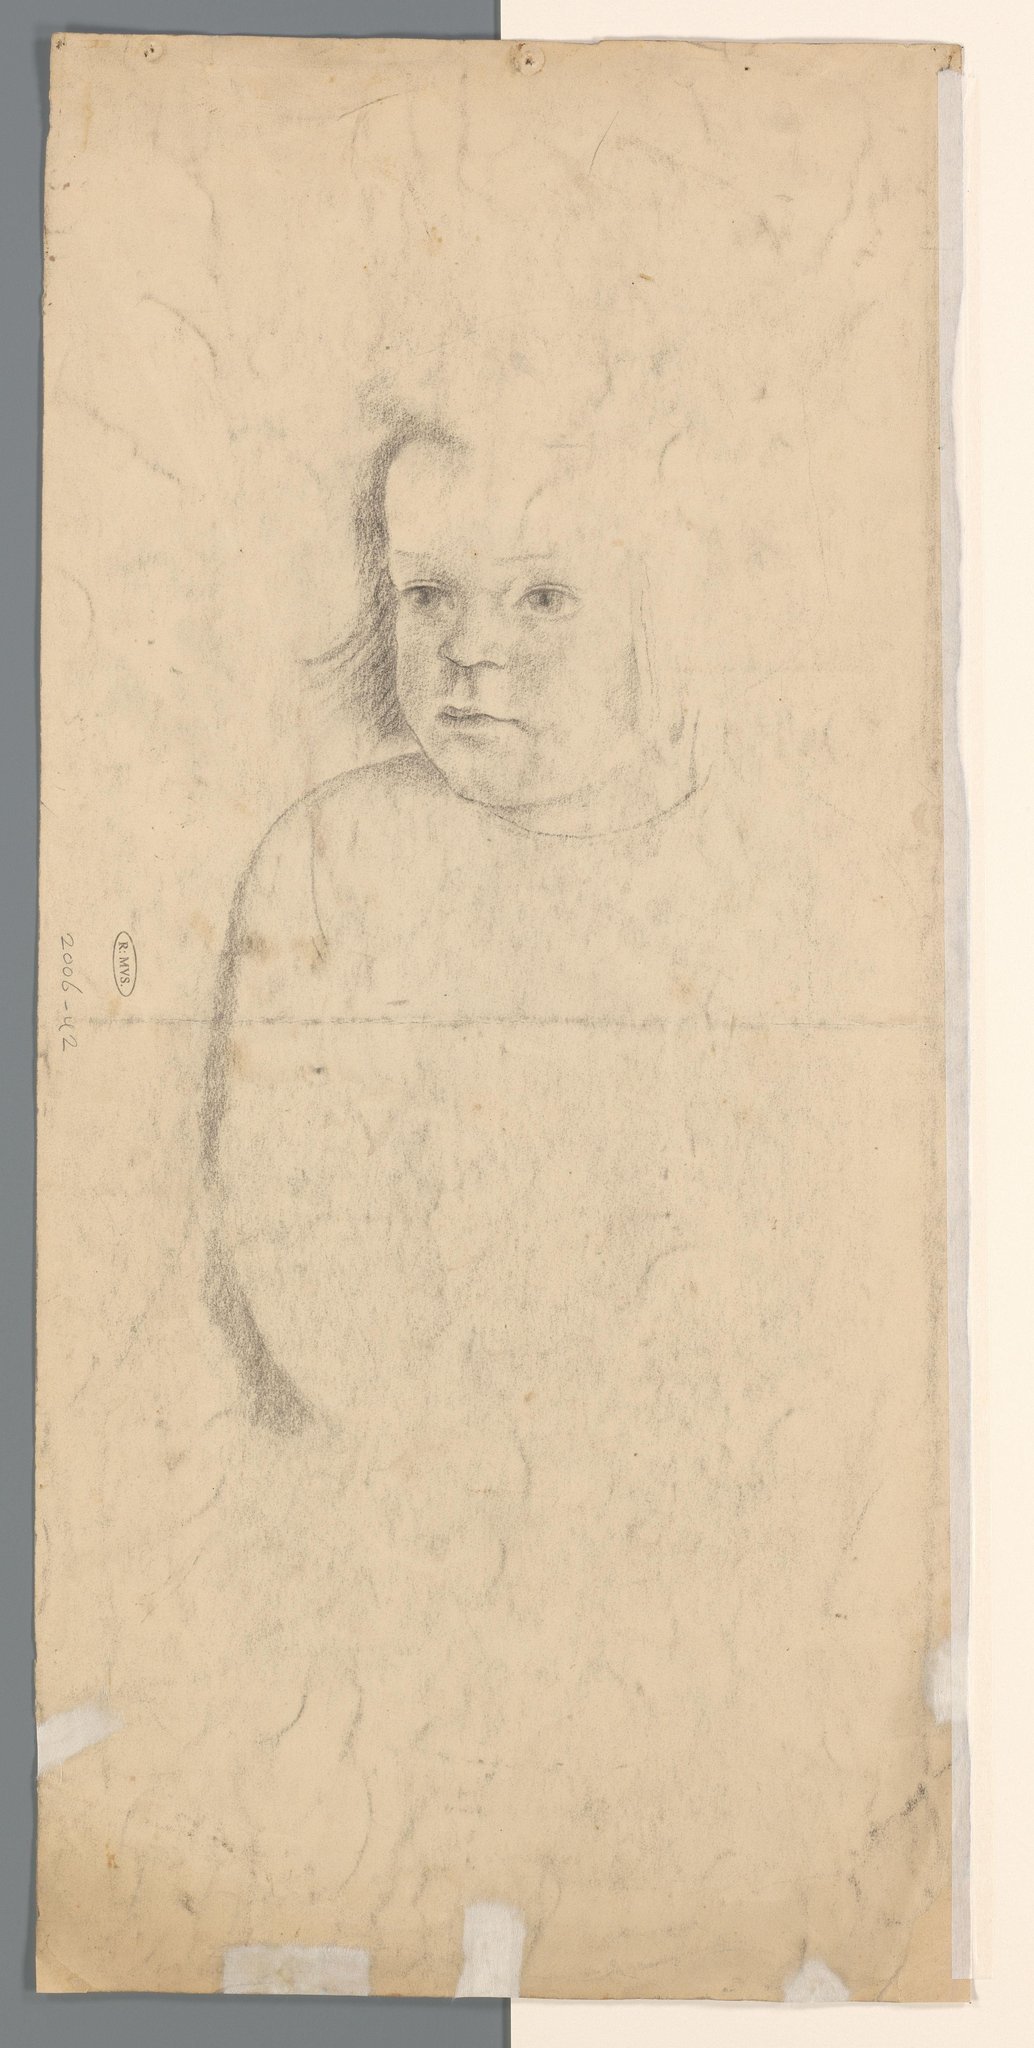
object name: drawing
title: Hoofd en bovenlichaam van een kind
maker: henk henriët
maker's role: draughtsman, print maker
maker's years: 1903-1945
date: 1913-1945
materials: chalk, paper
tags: child (at home)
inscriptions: collector's mark: Lugt 2228